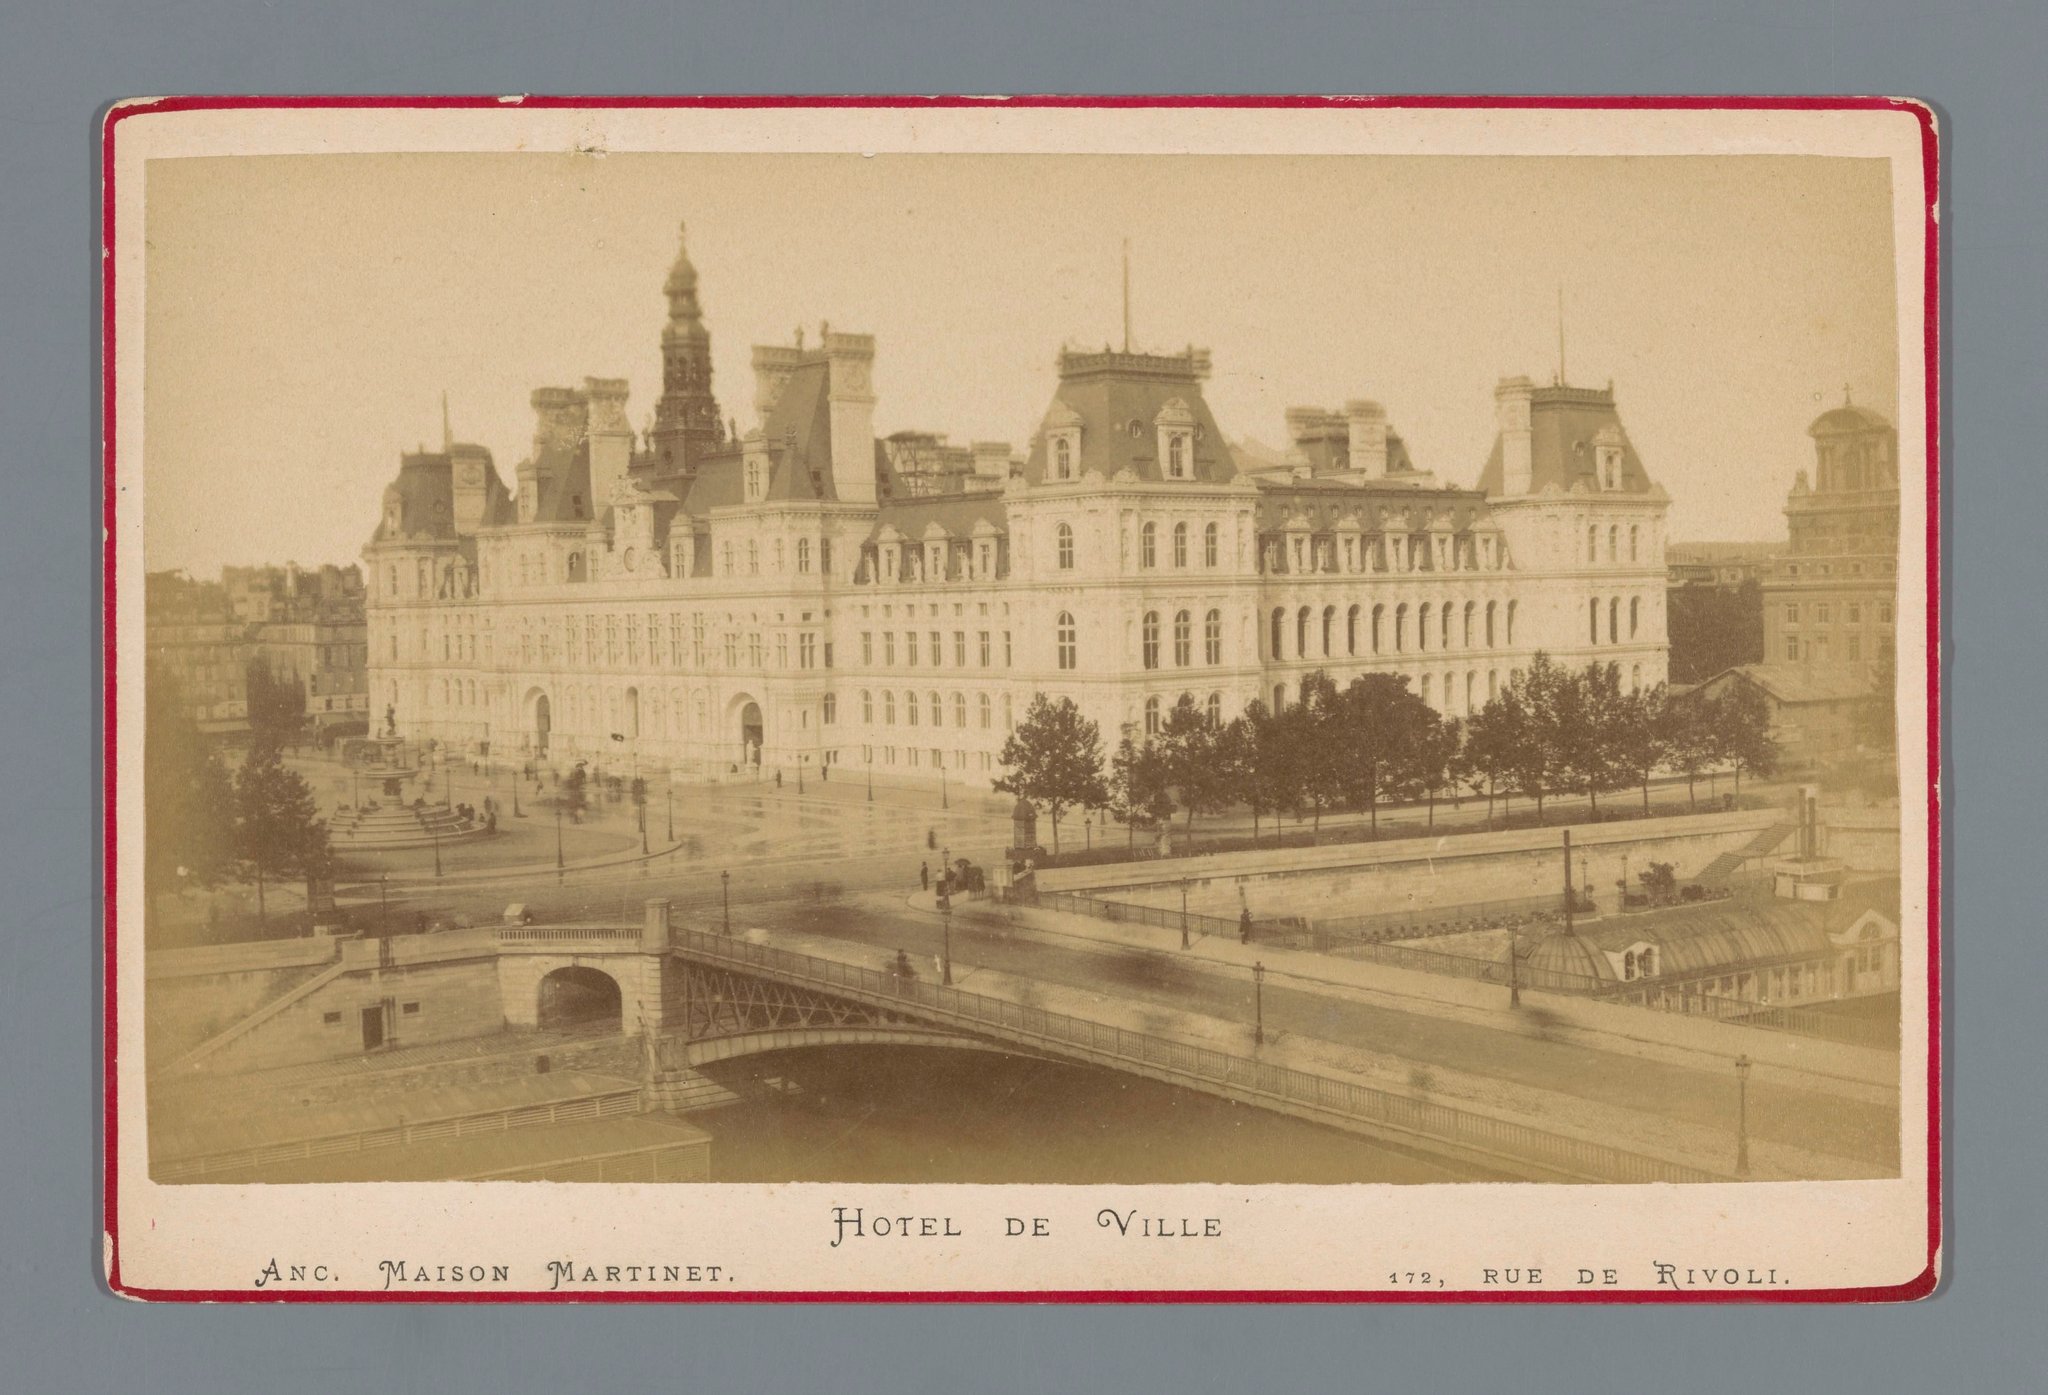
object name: photograph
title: Gezicht op het stadhuis van Parijs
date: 1860-1890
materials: cardboard, photographic support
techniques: albumen print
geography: paris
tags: townhall, façade (of house or building)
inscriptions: address: ‘172, rue de Rivoli.’